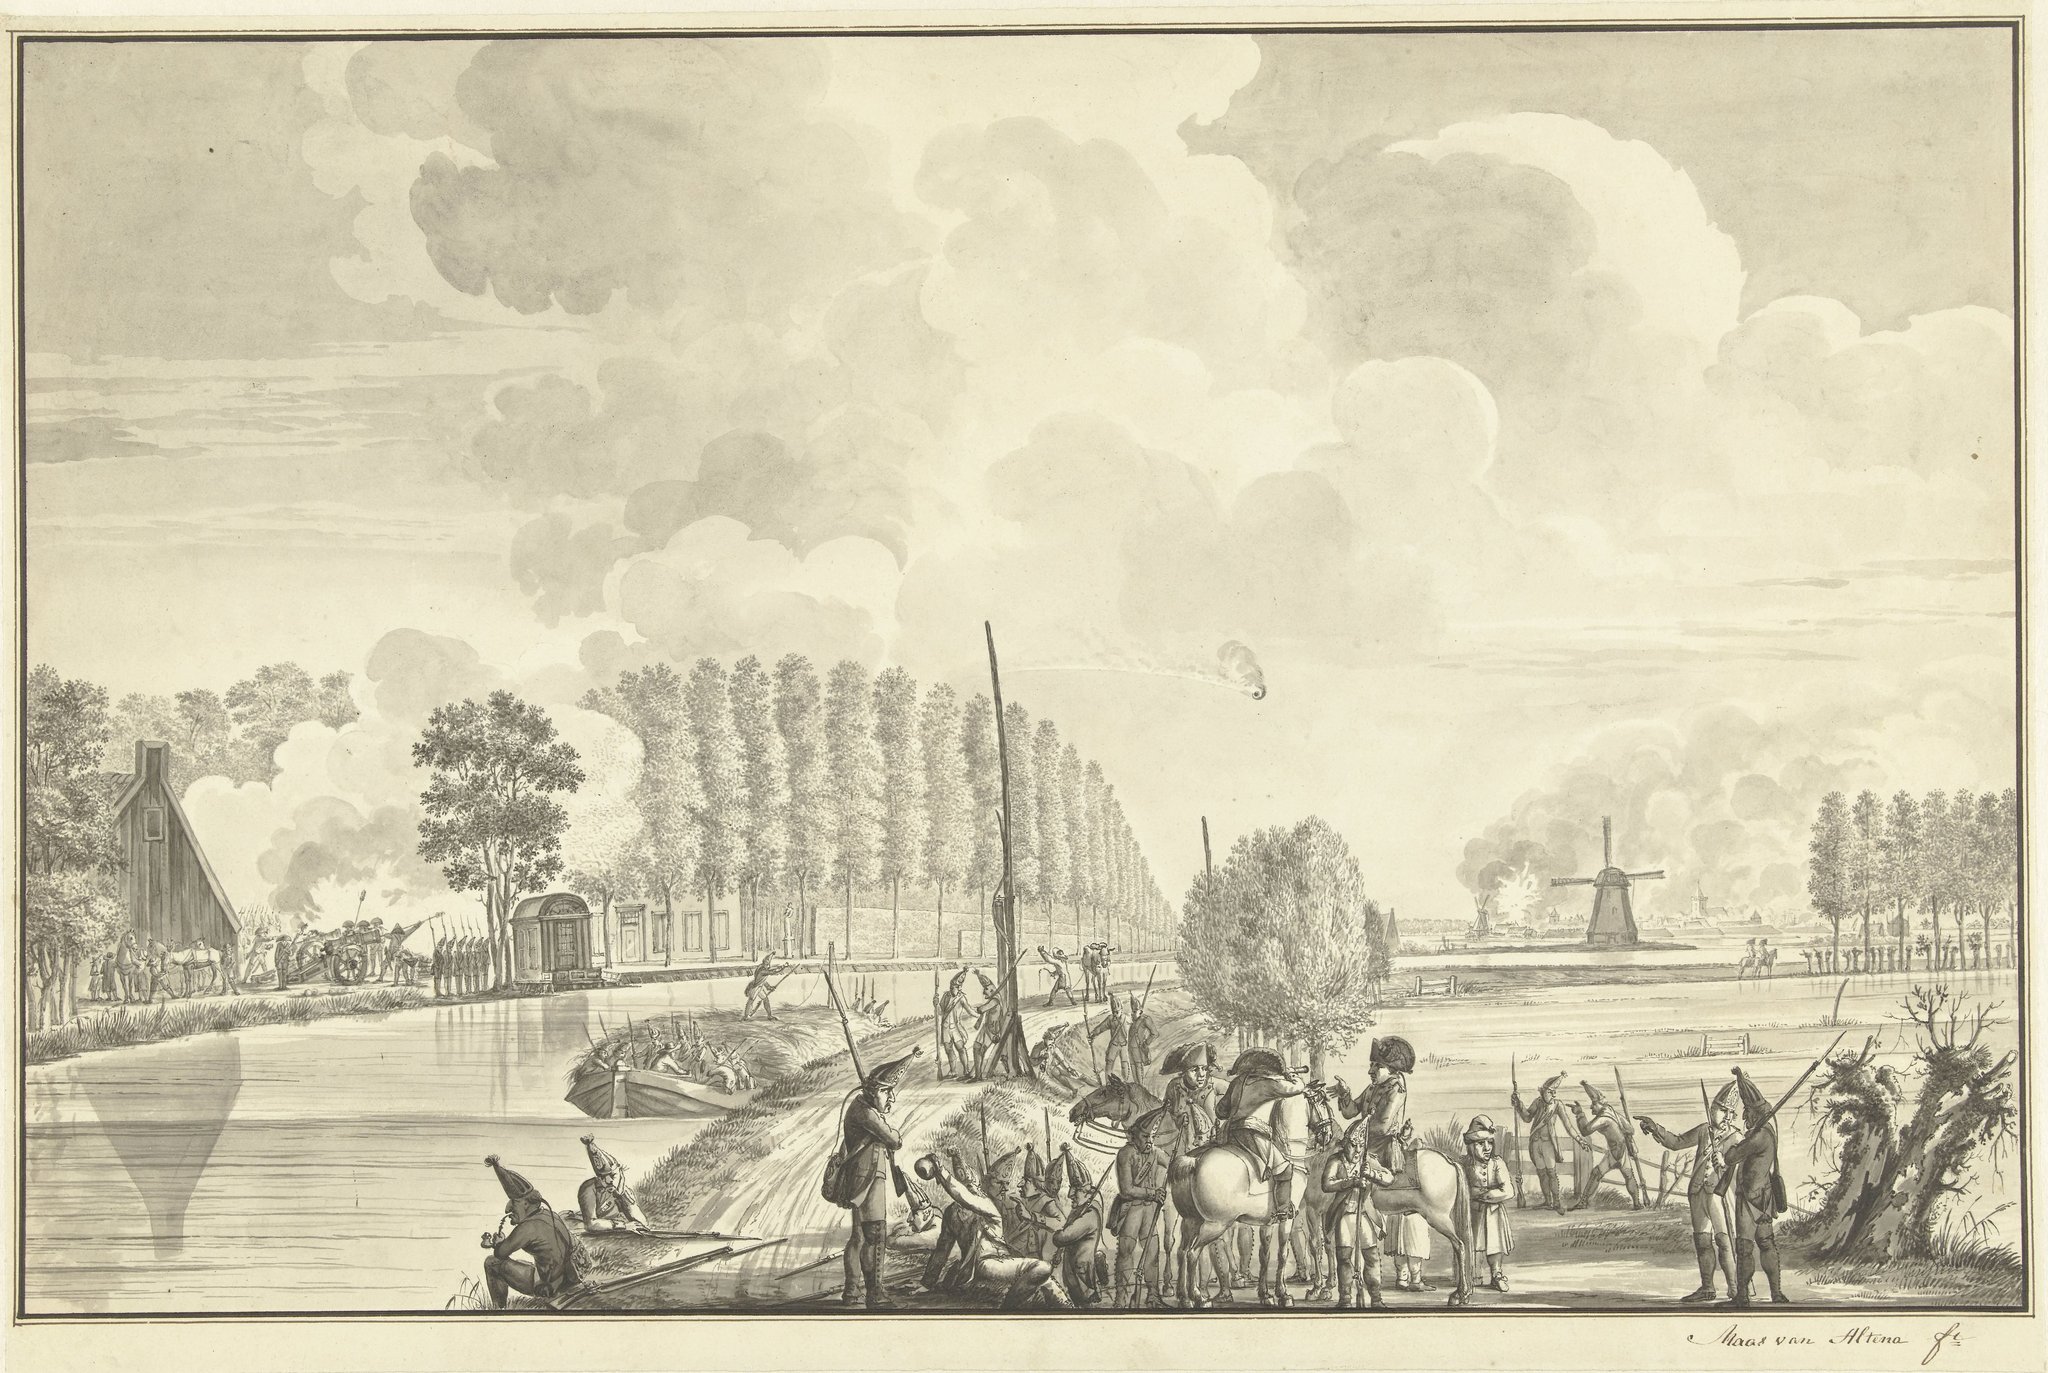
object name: drawing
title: Aanval op Muiden door generaal Kalckreuth, 1787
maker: maas van altena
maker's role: draughtsman, print maker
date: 1790-1792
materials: ink, paper, pencil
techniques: brush, pen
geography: northern netherlands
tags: berlin, battle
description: Aanval op de stad Muiden door de Pruisische troepen onder generaal Friedrich Adolf von Kalckreuth, verdedigd door Amsterdamse schutters onder kolonel Mattha, 1 oktober 1787. Op de voorgrond de Pruisen, op de achtergrond het bombardement van de stad. Ontwerp voor een prent.